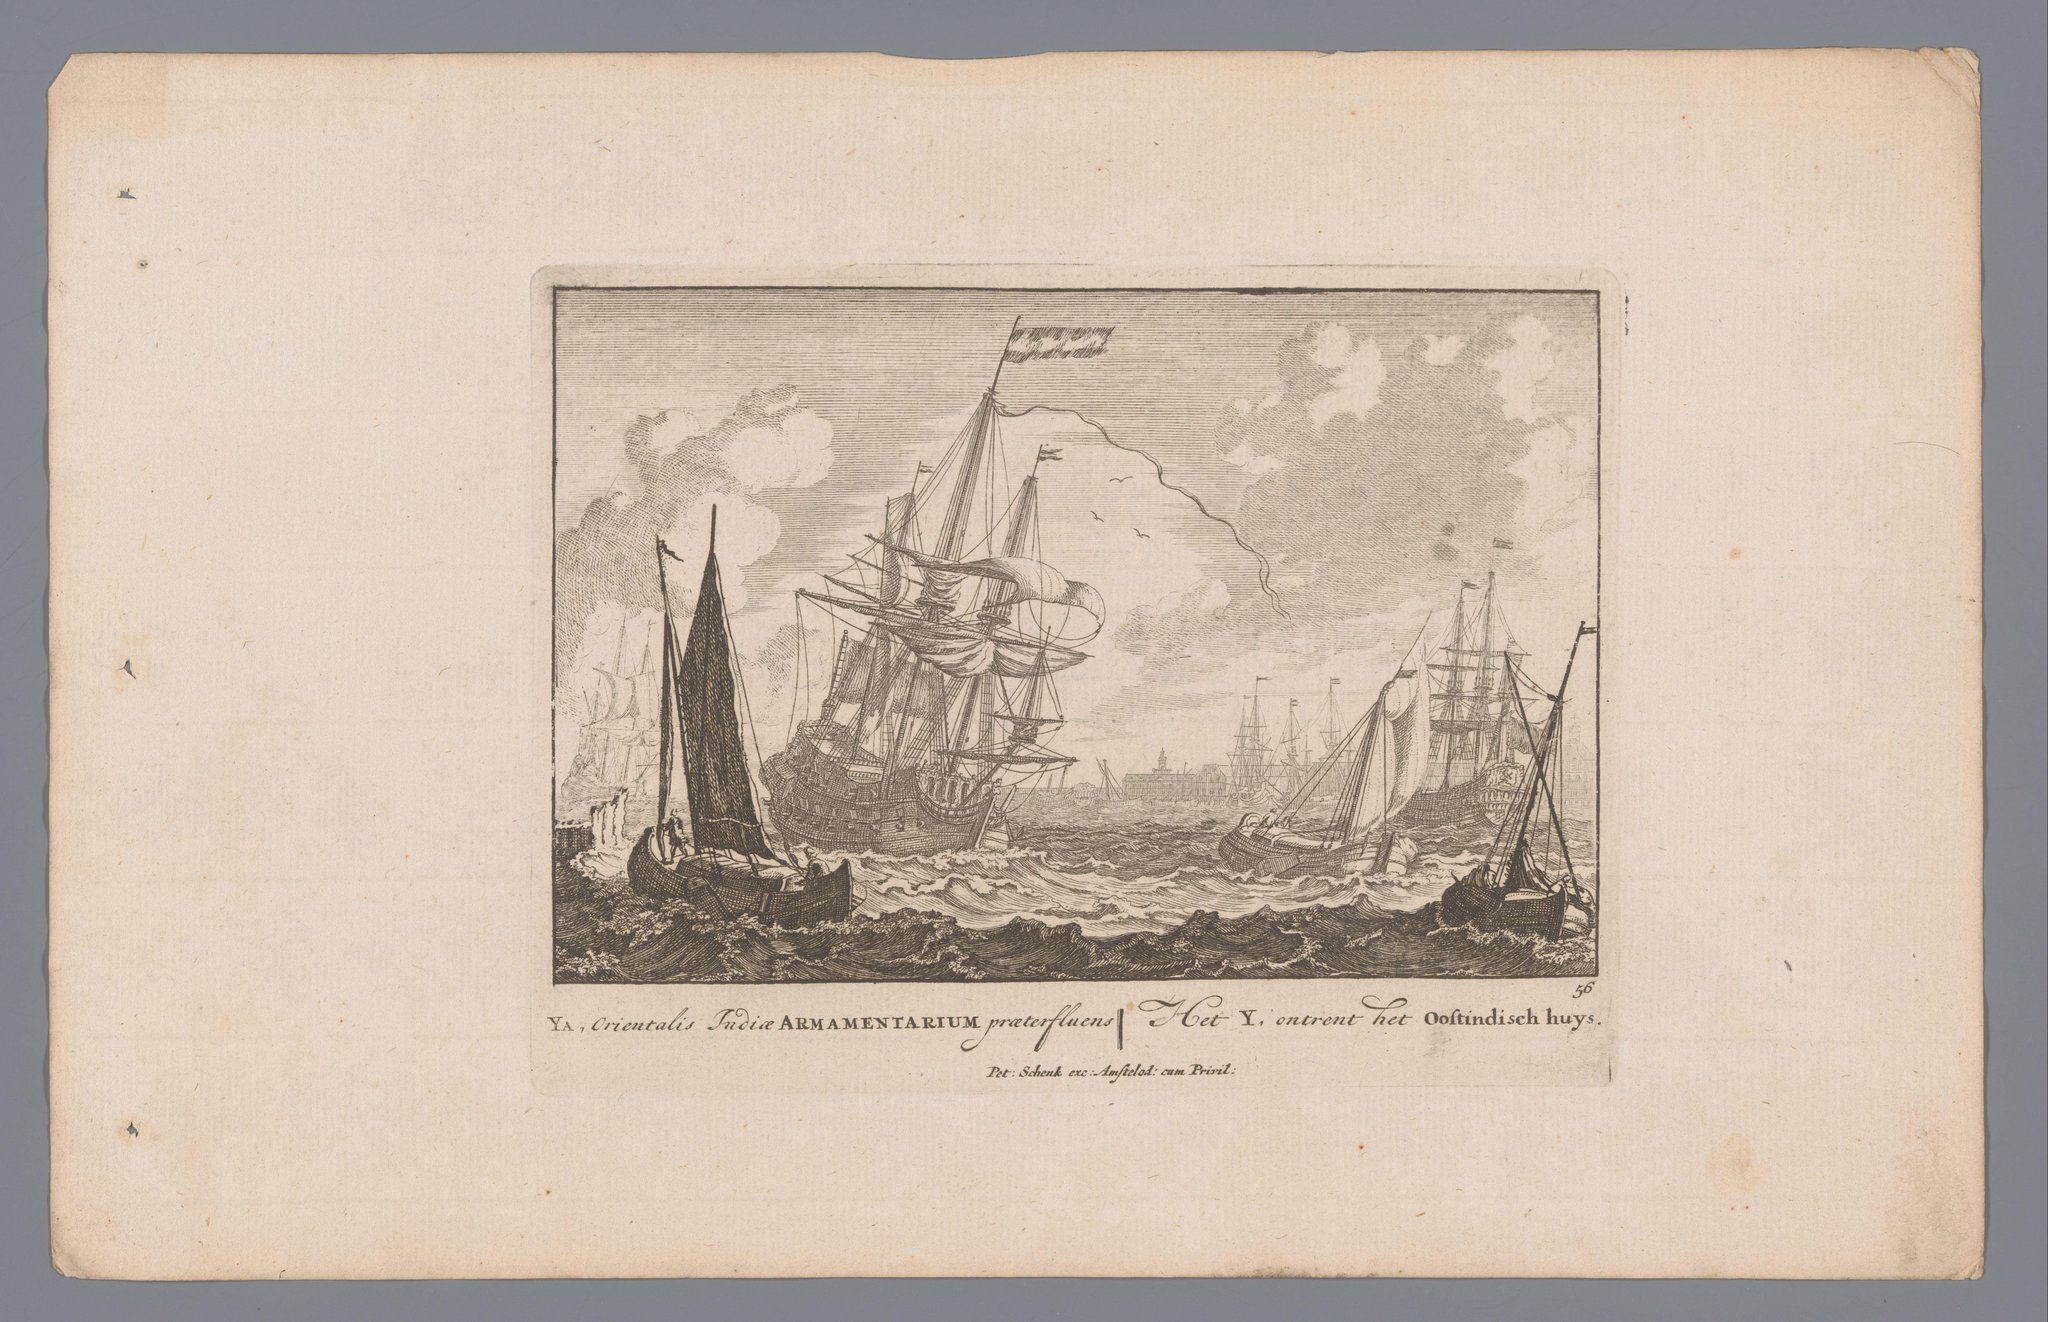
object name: print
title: Gezicht op het IJ nabij het Oost-Indisch Huis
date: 1694-1697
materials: paper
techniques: etching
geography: amsterdam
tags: harbour, city-view, and landscape with man-made constructions, ships (in general) - cc - more than one ship, amsterdam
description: Prent uit: Admirandorum Quadruplex Spectaculum. Amsterdam: Pieter Schenk (I), [1694-1697]. In Hollstein vermeld bij een serie van 100 prenten over Amsterdam, maar de prenten die in Hollstein worden genoemd zijn groter.